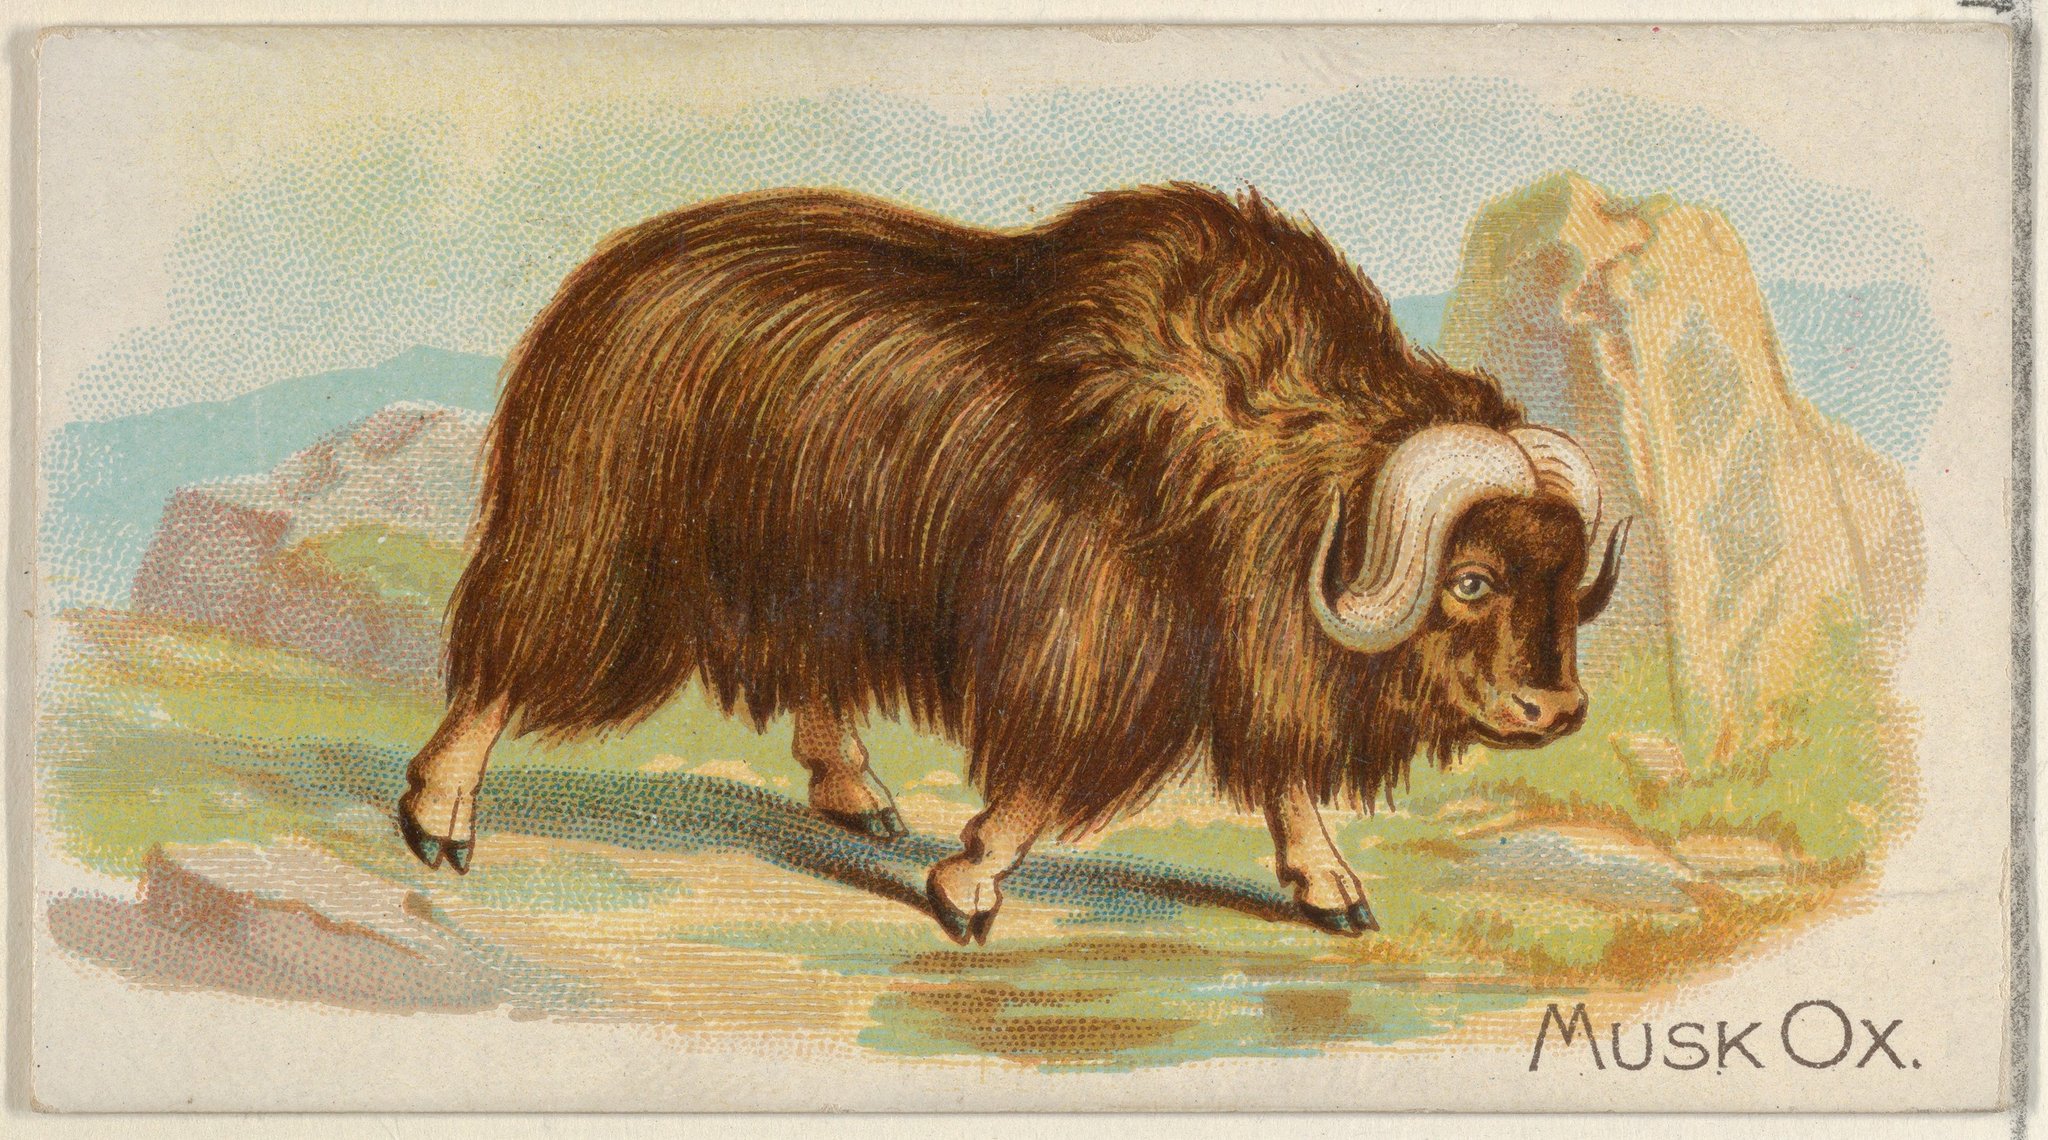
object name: print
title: Musk Ox, from the Quadrupeds series (N21) for Allen & Ginter Cigarettes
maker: allen & ginter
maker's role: publisher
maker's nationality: american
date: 1890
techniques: color lithograph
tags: animals